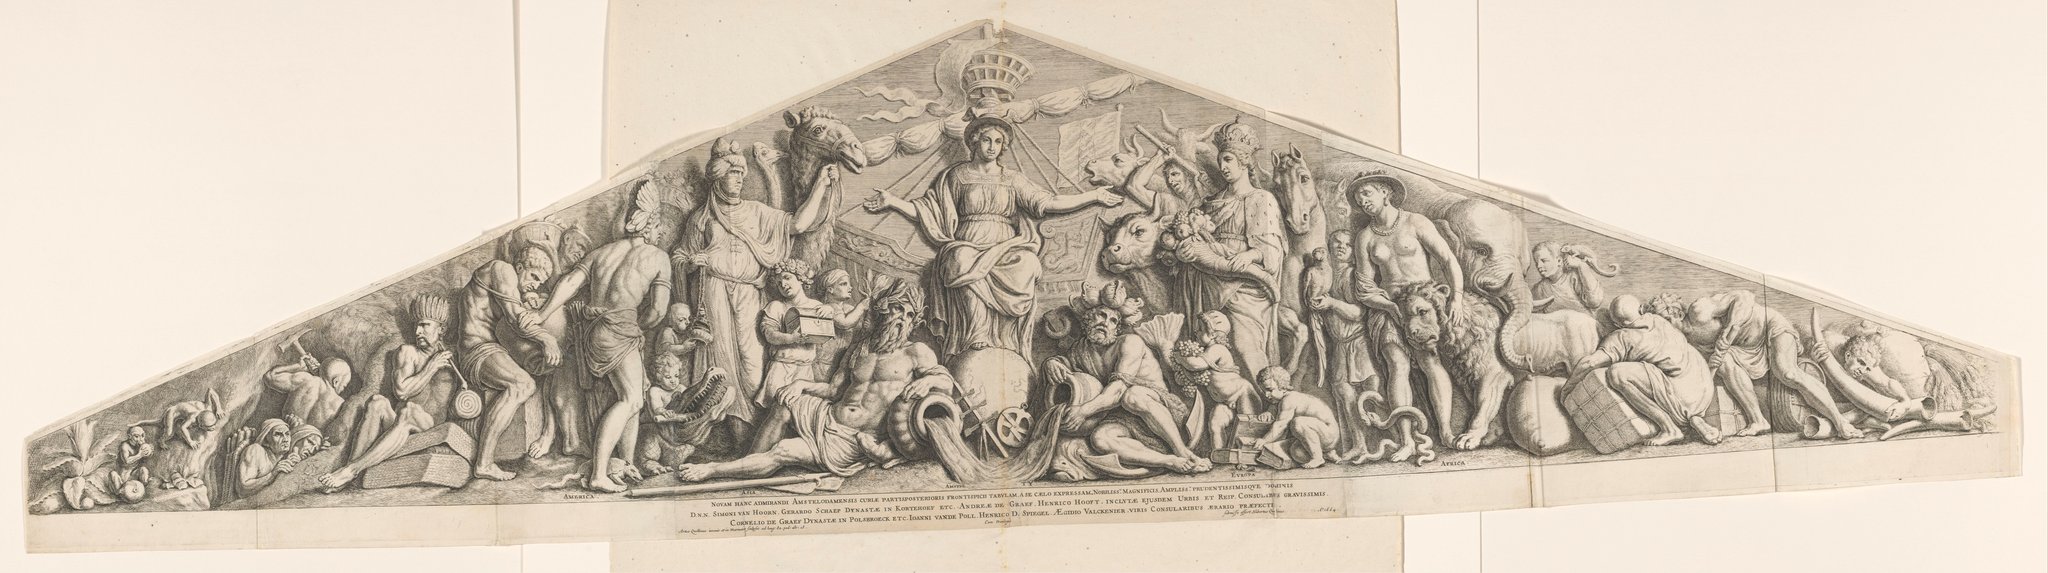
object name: print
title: Allegorie op de handel van Amsterdam met de vier continenten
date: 1664-1668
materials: paper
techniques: engraving, etching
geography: amsterdam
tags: hoofed animals: camel, 'cornucopia', horn of plenty, sailing-ship, sailing-boat, hoofed animals: dromedary, swimming mammals: dolphin, europe represented allegorically; 'europa' (ripa), fishing net, asia represented allegorically; 'asia' (ripa), africa represented allegorically; 'africa' (ripa), personification of a city, town-patron(ess), america represented allegorically; 'america' (ripa), river personified, 'fiumi' (ripa), indigenous peoples of north america (+ costume), flag, colours (as symbol of the state, etc.) (+ city; municipal), beasts of prey, predatory animals: otter, river-gods, allegory of trade; 'commertio della vita humana' (ripa), beasts of prey, predatory animals: lion, continents represented allegorically, position-finding at sea; nautical instruments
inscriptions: collector's mark: Lugt 195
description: Huidige staat van prent ook gebruikt in later ingebonden exemplaren van: Secunca pars Praecipuarum effigierum ac ornamentorum amplissime Curiae Amstelrodamensis maiori ex parte in cadido marmore effectorum per Artum Quellinium eiusdem Civitatis Statuarium / Het tweede deel Van de voornaemste Statuen ende Cieraten van 't konst-rijcke Stadt-huys van Amstelredam 'tmeeste in Marmer gemaeckt door Artus Quellinus Beelthouwer der voorseyde Stadt. Amsterdam: Artus Quellinus (I), 1663. En in: Secunca pars Praecipuarum effigierum ac ornamentorum amplissime Curiae Amstelrodamensis maiori ex parte in cadido marmore effectorum per Artum Quellinium eiusdem Civitatis Statuarium / Het tweede deel Van de voornaemste Statuen ende Cieraten van 't konst-rijcke Stadt-huys van Amstelredam 'tmeeste in Marmer gemaeckt door Artus Quellinus Beelthouwer der voorseyde Stadt. Amsterdam: Frederik de Wit, 1668. Latere staat van prent ook gebruikt in: Architecture peinture et sculpture de la Maison de Ville d'Amsterdam, representee en CIX. figures en taille-douce (…). Amsterdam: David Mortier, 1719. En in: Architecture peinture et sculpture de la Maison de Ville d'Amsterdam, representee en CIX. figures en taille-douce (…). Amsterdam: Gerard Valck, 1719. En in: Bouw schilder en beeldhouwkonst, van het Stadhuis te Amsteldam, vertoont in CIX figuuren (…). Amsterdam: Covens & Mortier & Covens Jr., s.a. (1774-1783). Zie BK-AM-51-3 voor model van beeld.